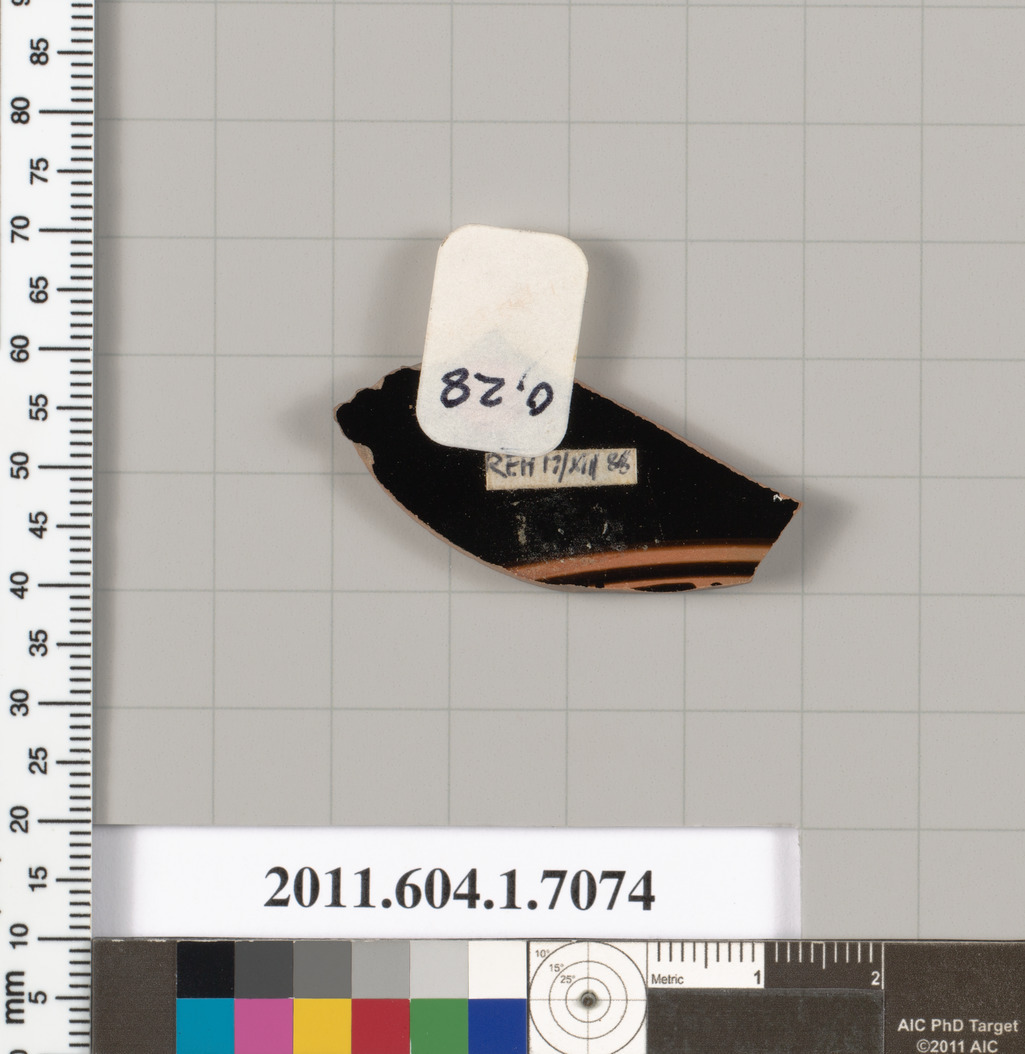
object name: kylix fragment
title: Terracotta fragment of a kylix (drinking cup)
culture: greek, attic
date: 500-480 BCE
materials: terracotta